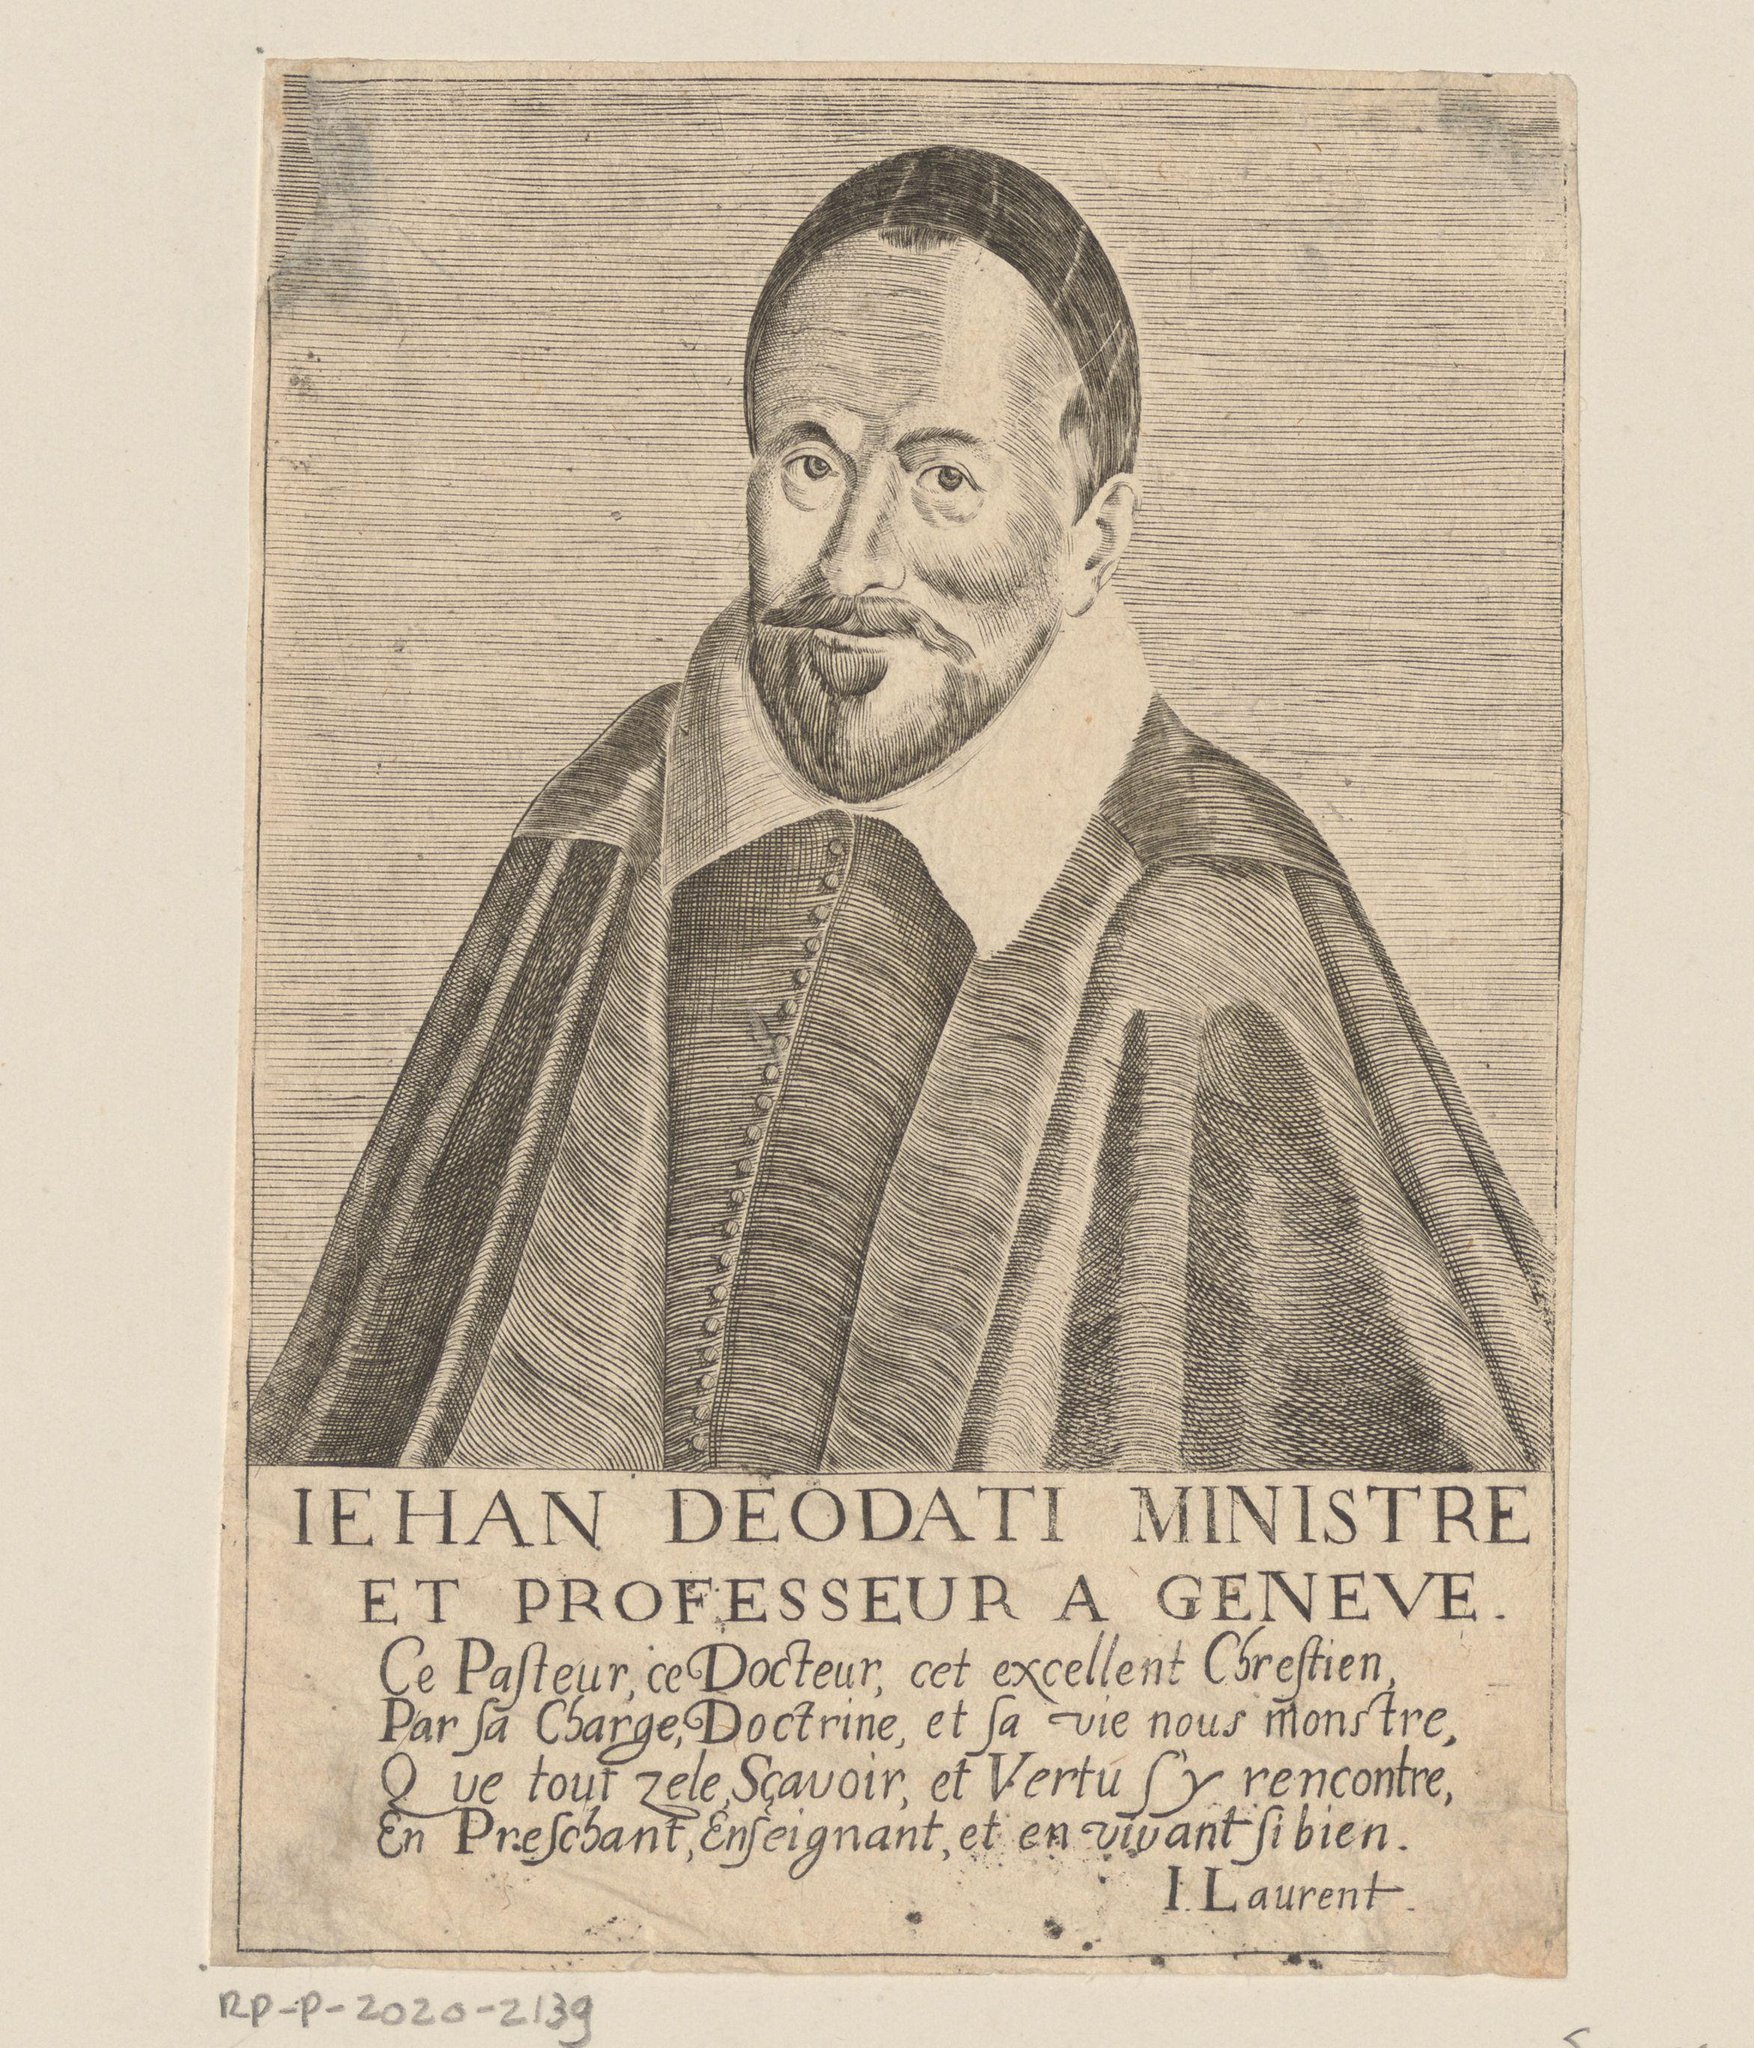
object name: print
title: Portret van Giovanni Diodati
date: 1600-1699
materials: paper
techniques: engraving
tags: theologian, historical persons